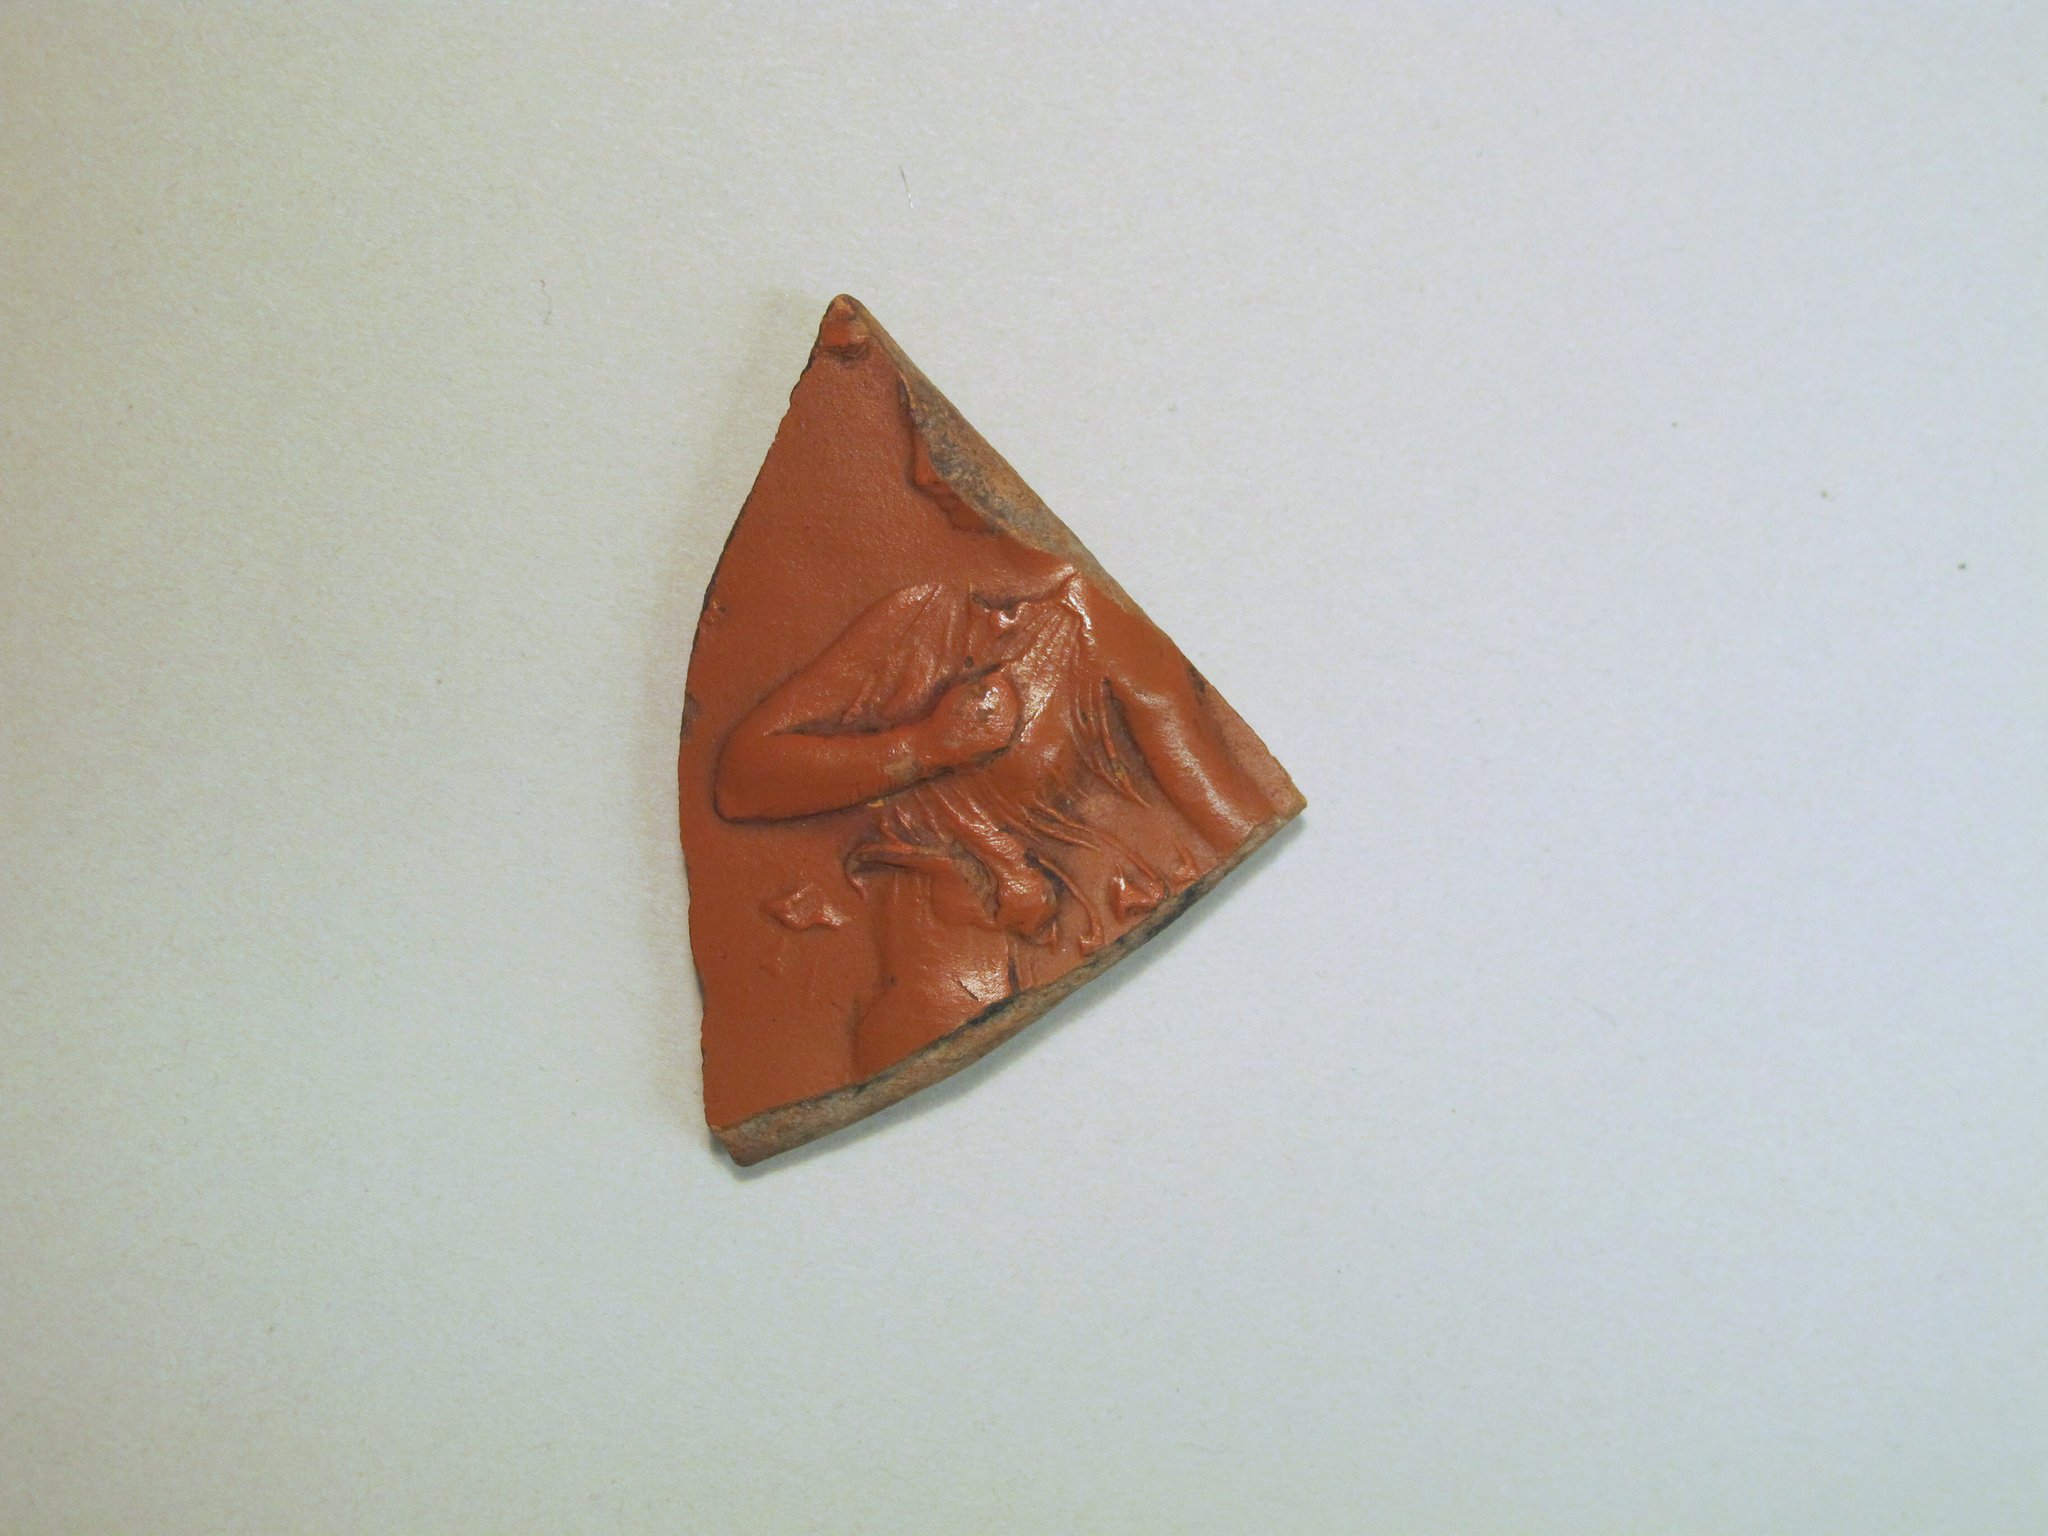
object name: vase fragment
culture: roman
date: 670 BCE-330 CE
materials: terracotta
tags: women,dancing